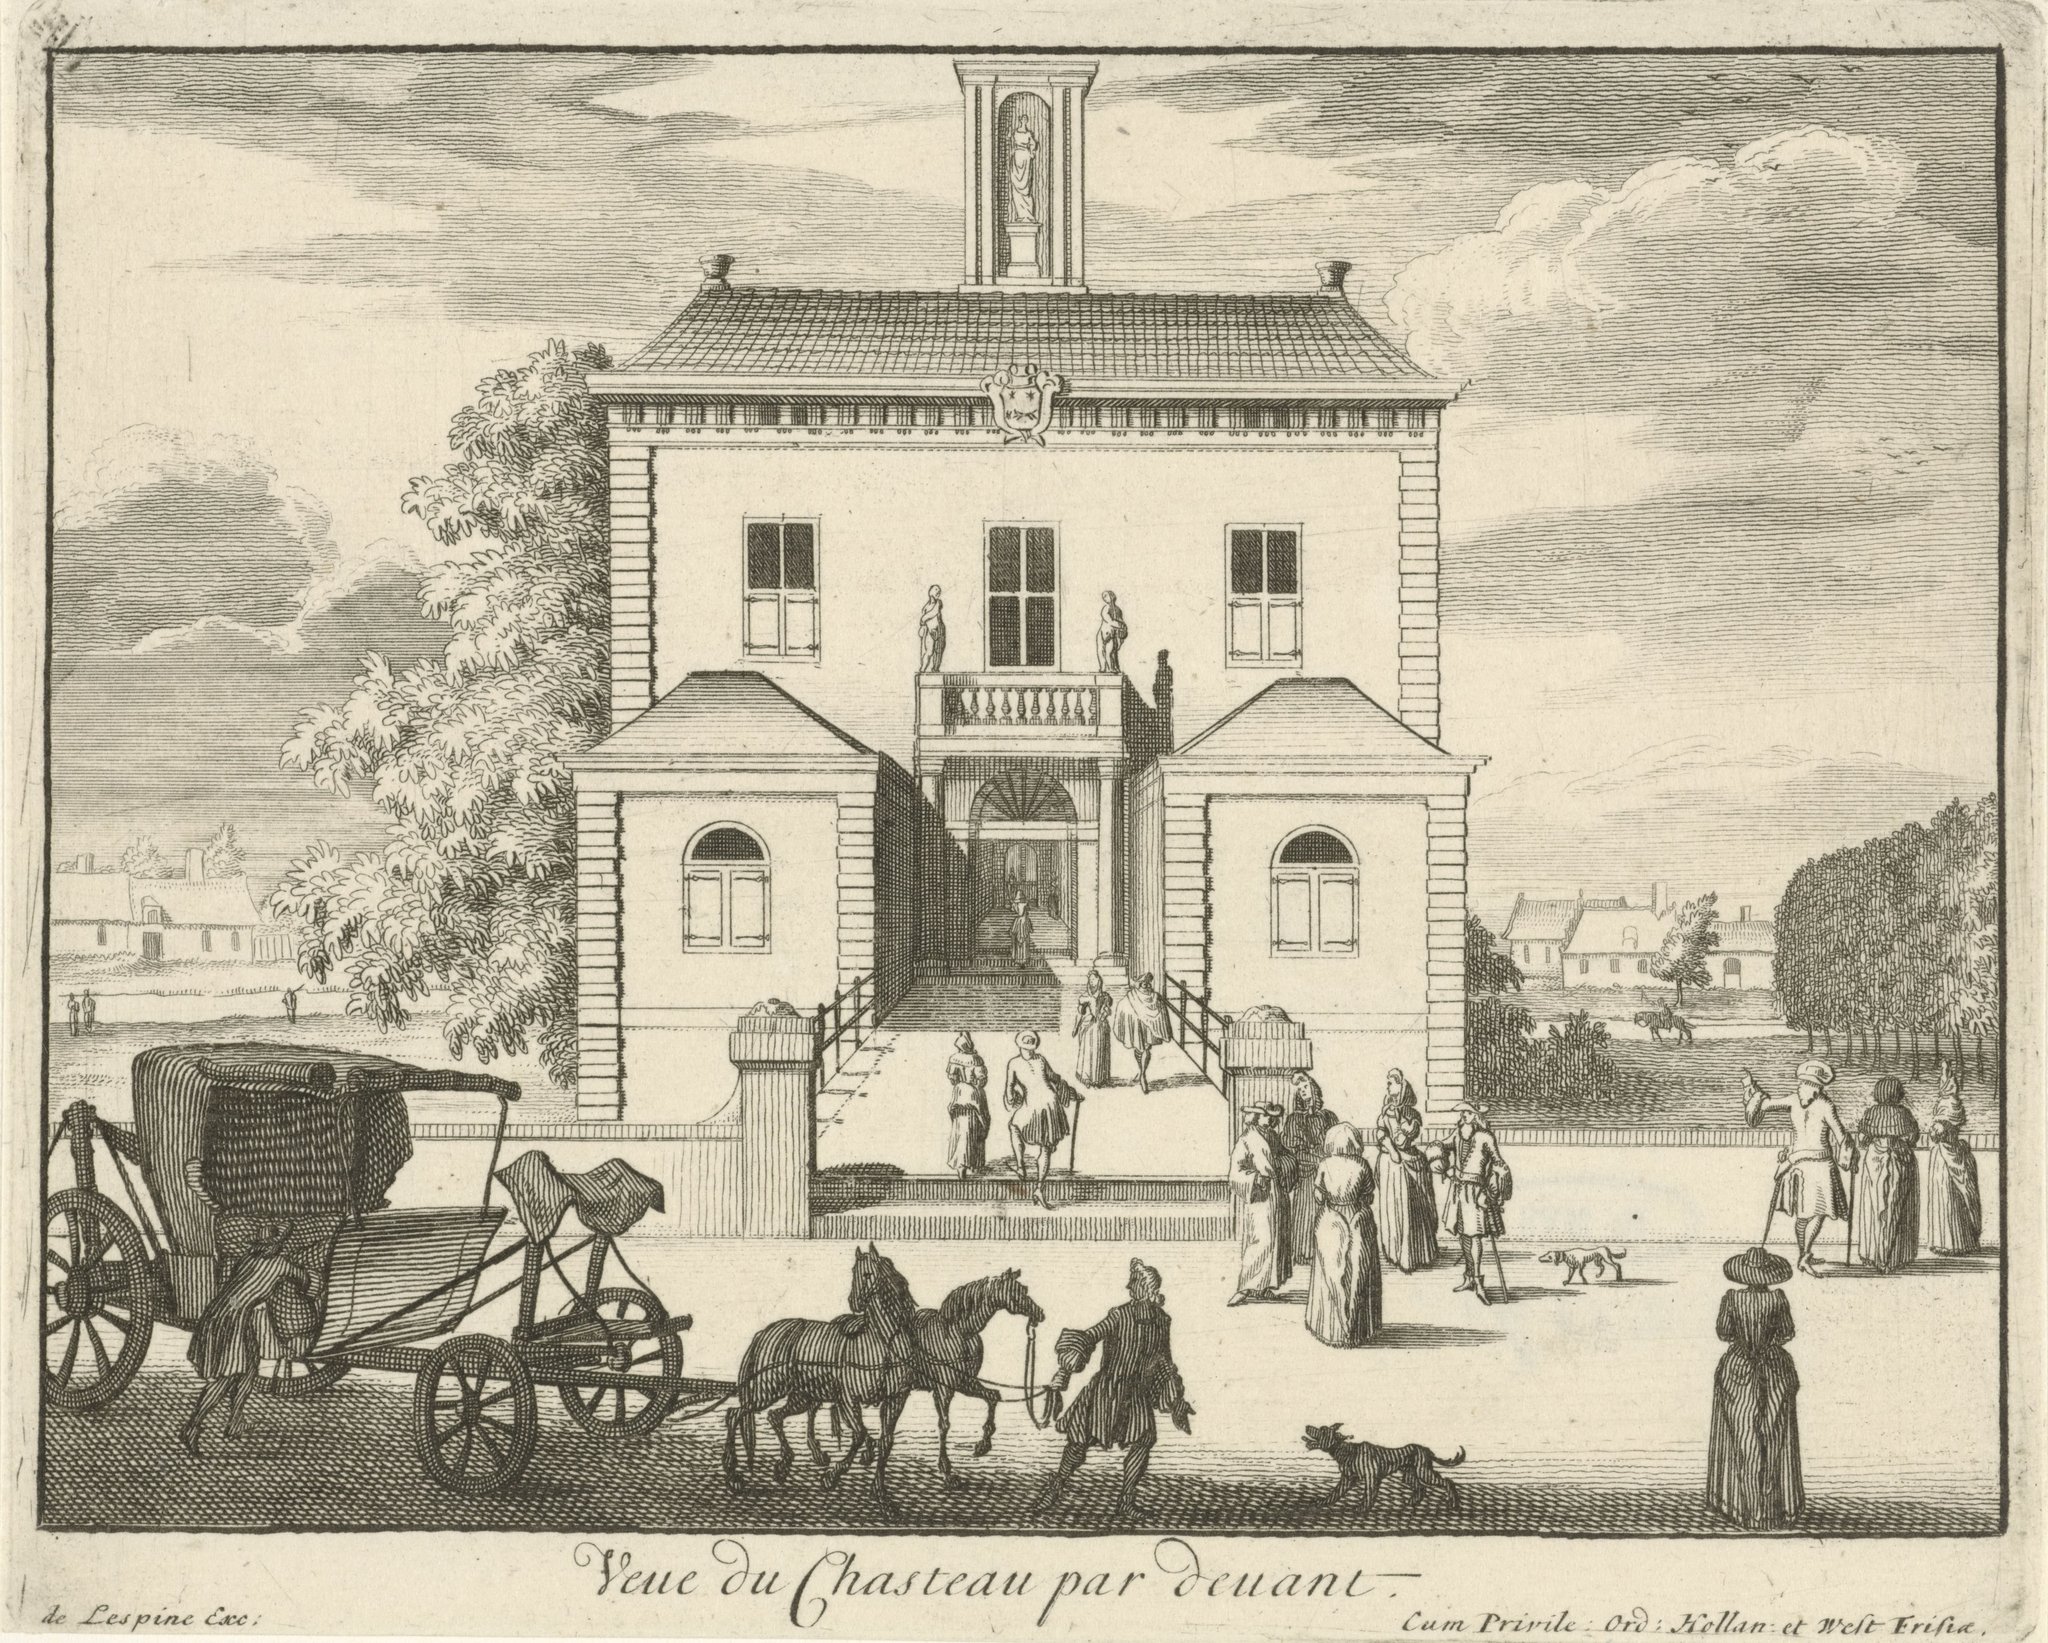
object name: print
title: Voorzijde van Kasteel Gunterstein, Breukelen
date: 1680-1696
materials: paper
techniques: engraving, etching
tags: magdalena poulle, castle, four-wheeled, animal-drawn vehicle, e.g.: cab, carriage, coach, exterior ~ architectural design or model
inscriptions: collector's mark: Lugt 2228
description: De voorzijde van Kasteel Gunterstein te Breukelen met op de voorgrond figuren en een stilstaande koets.